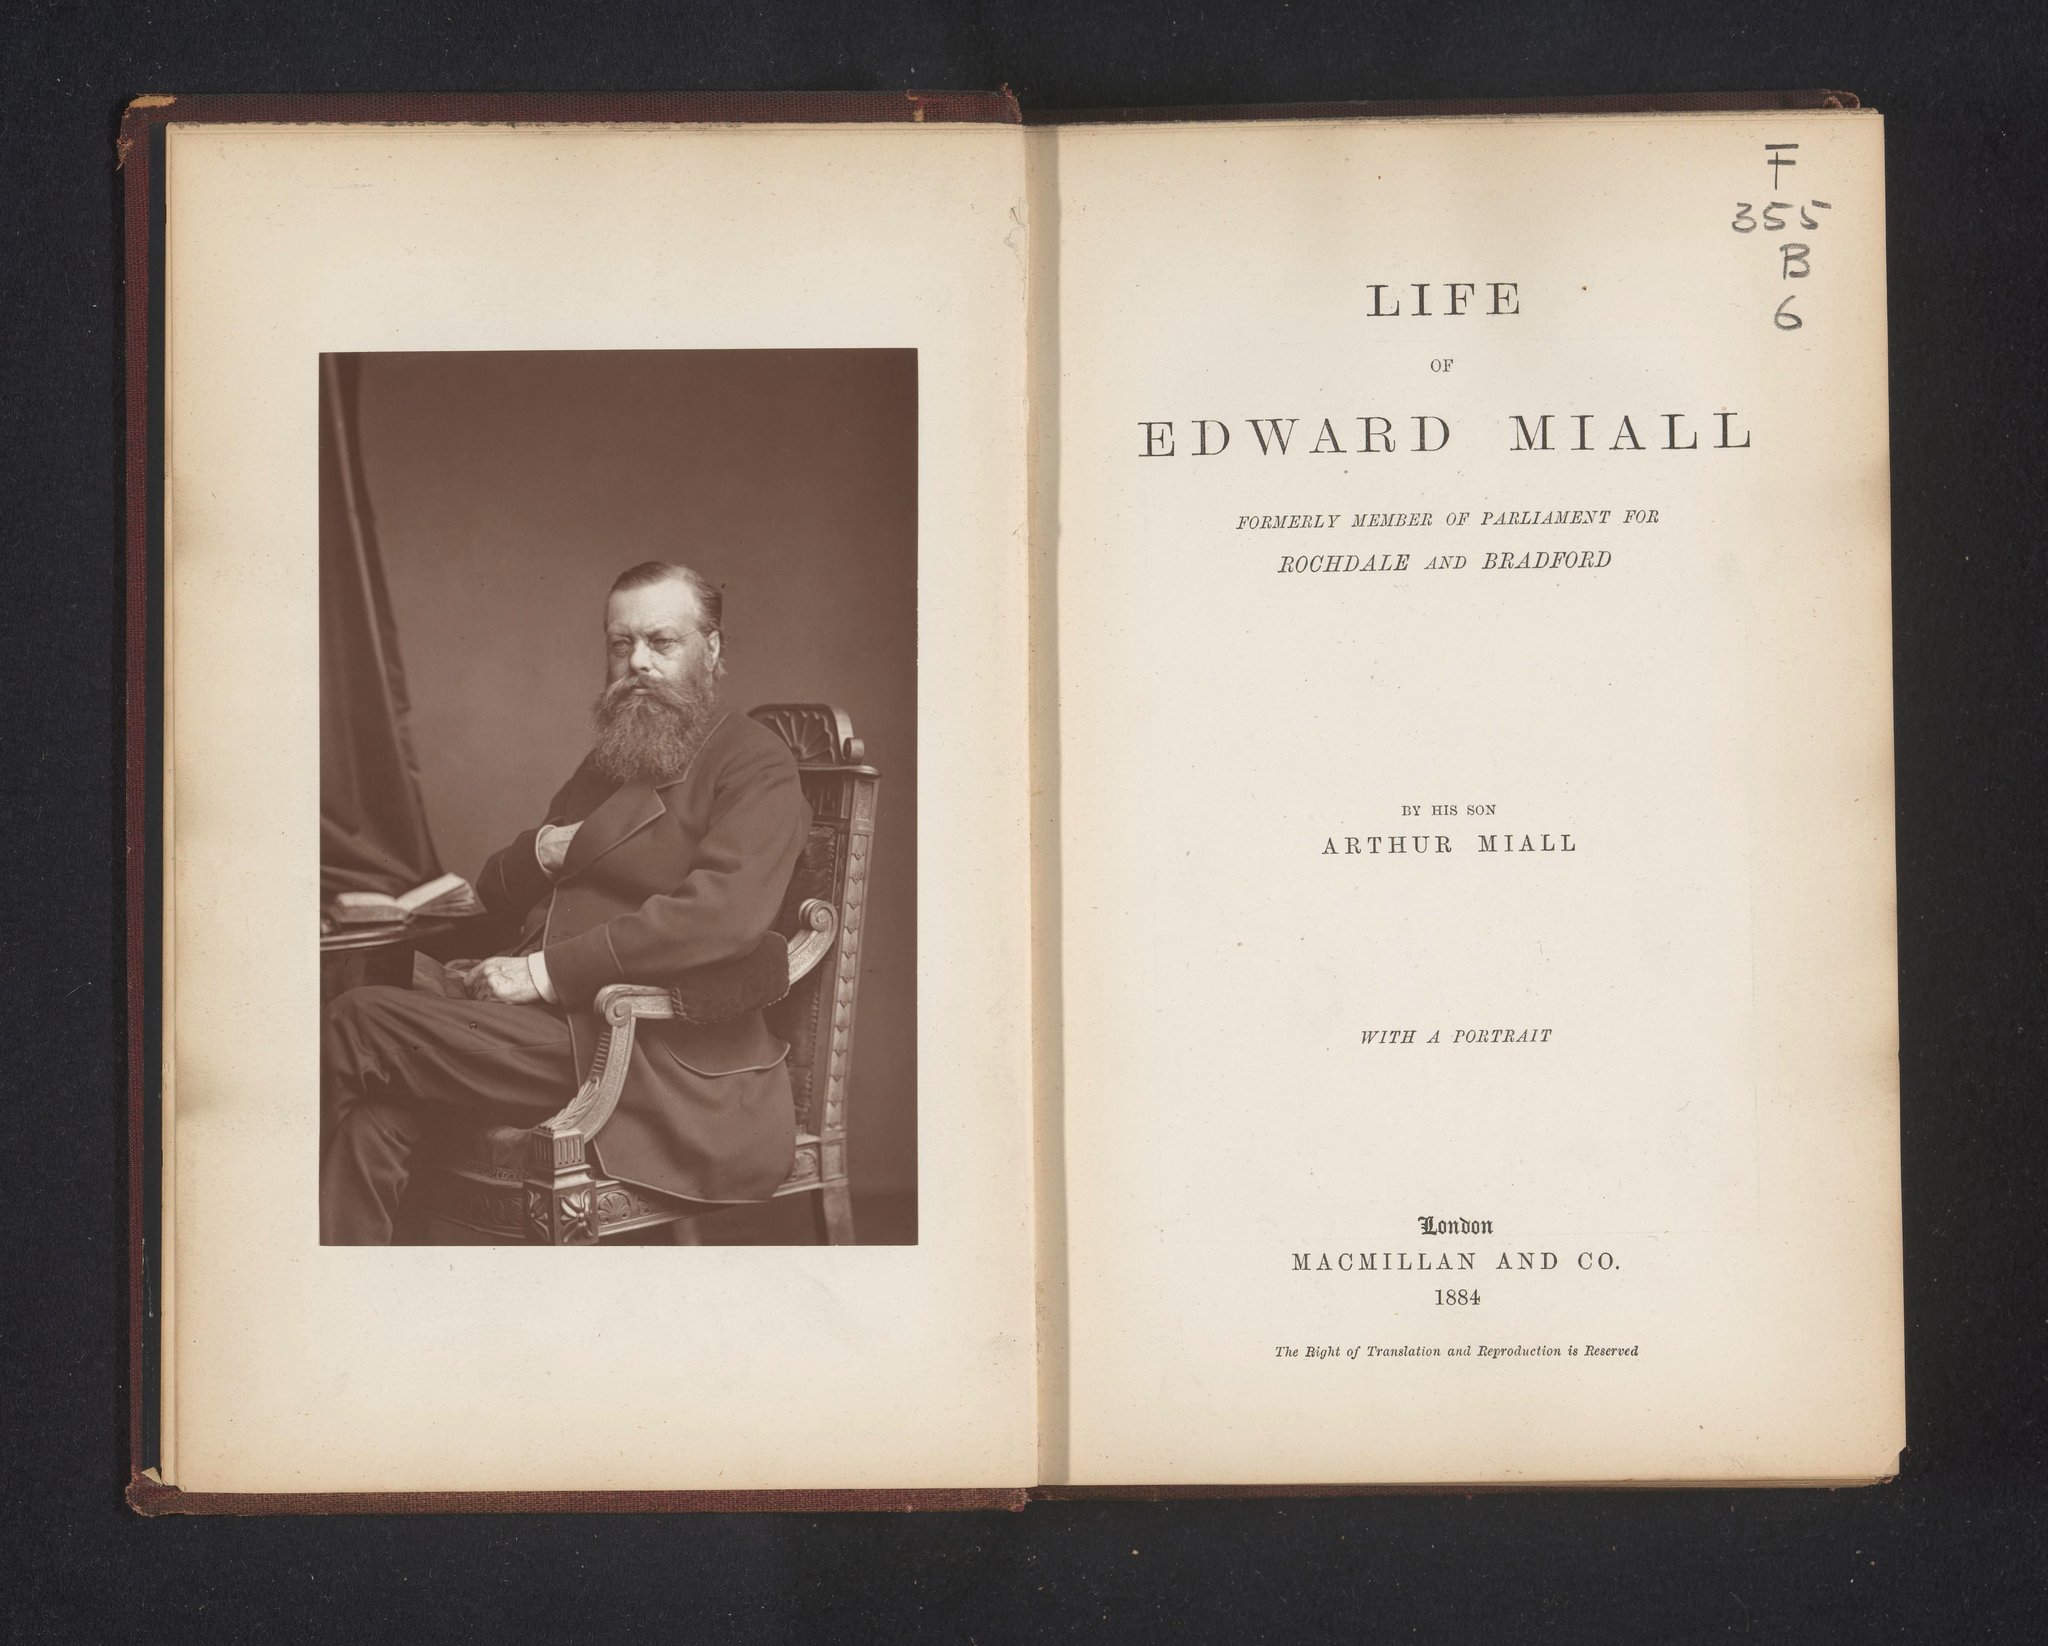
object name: book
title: Life of Edward Miall formerly member of Parliament for Rochdale and Bradford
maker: arthur miall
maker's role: publisher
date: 1884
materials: cardboard, linen, paper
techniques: printing, woodburytype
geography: london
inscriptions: inscription: ‘The Working Men's College Library presented by the Author, 1885 (...) such loss or damage.’, inscription: ‘Working Men's College Library 45, Great Ormond St.W.C.’, inscription: ‘From the Author’